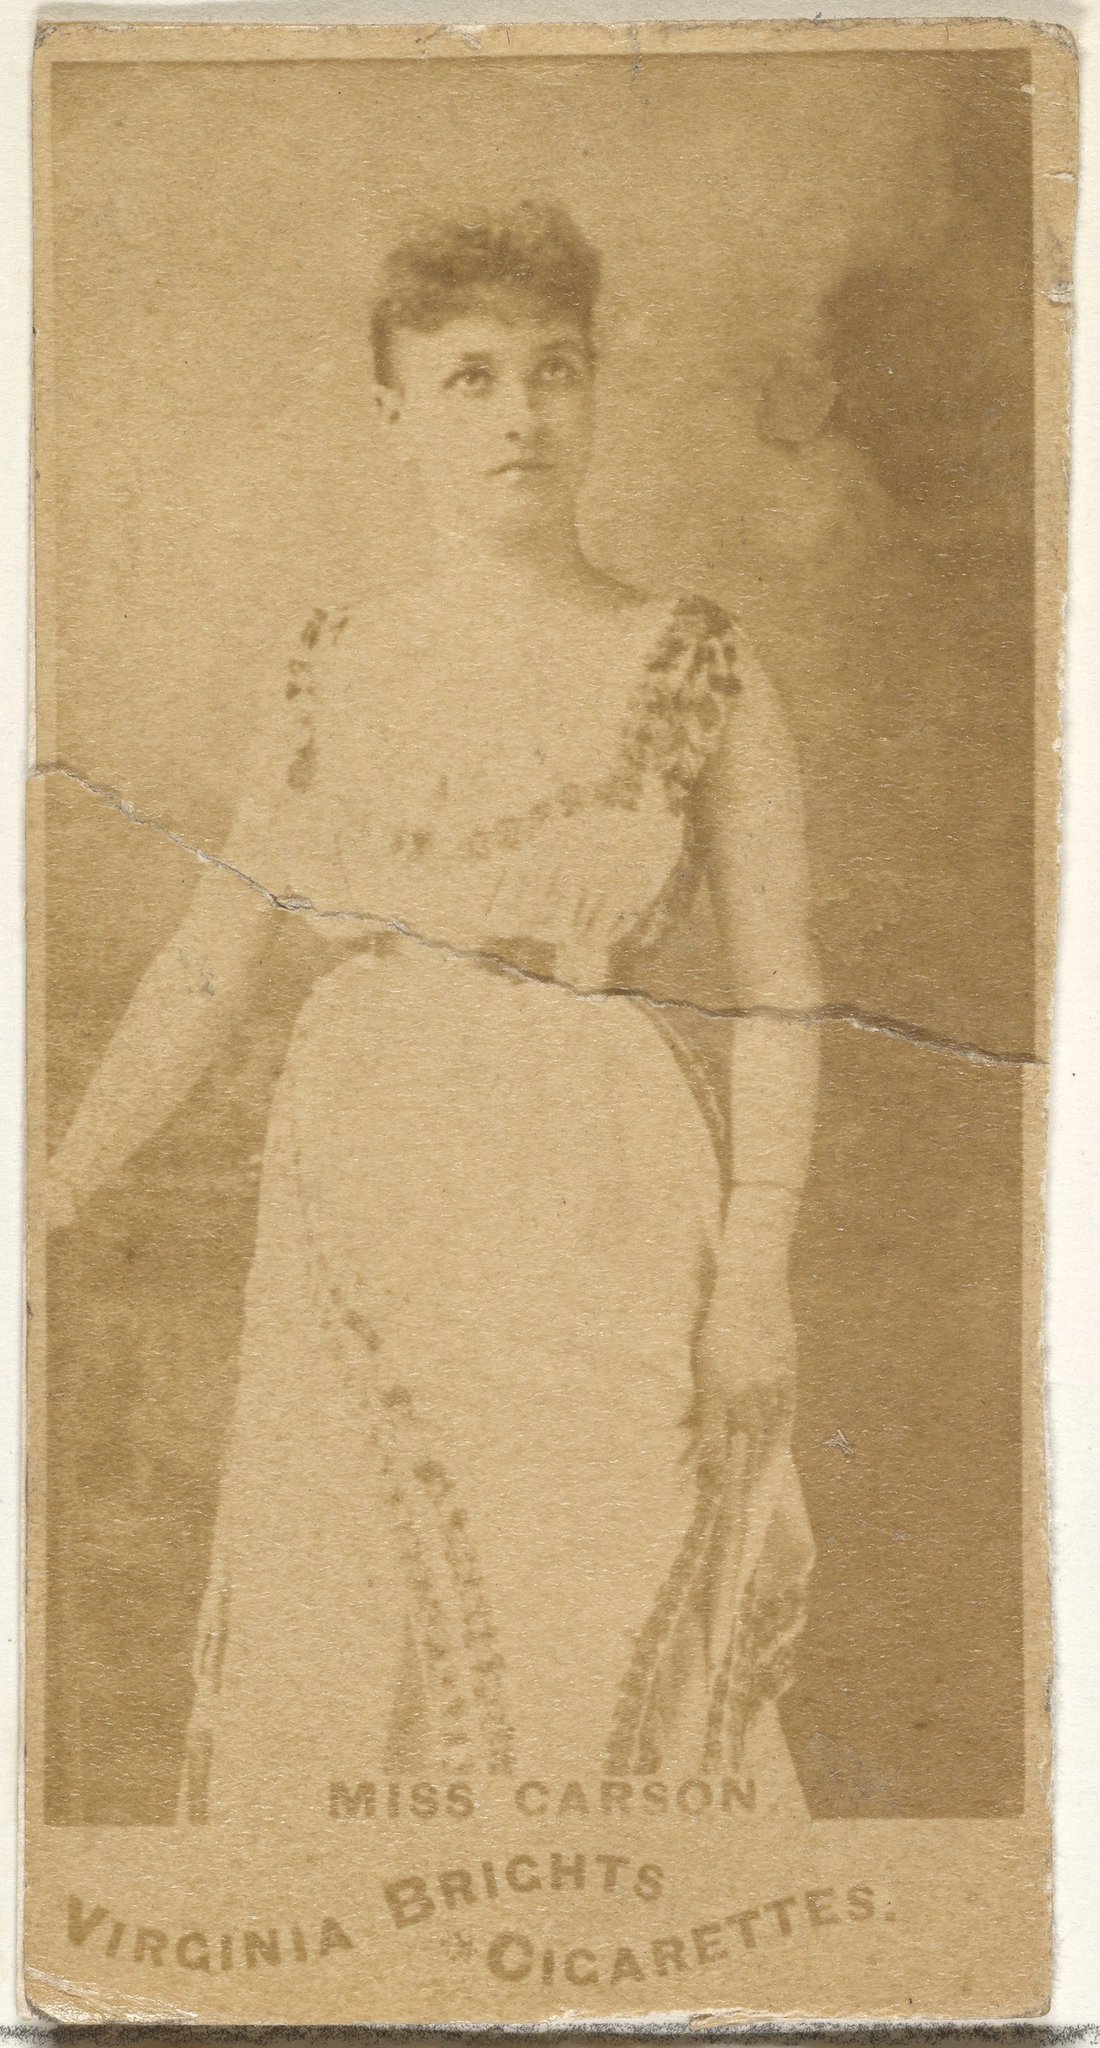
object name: photograph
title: Miss Carson, from the Actors and Actresses series (N45, Type 1) for Virginia Brights Cigarettes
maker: allen & ginter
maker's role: publisher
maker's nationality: american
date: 1888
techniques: albumen silver print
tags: portraits,women,actresses